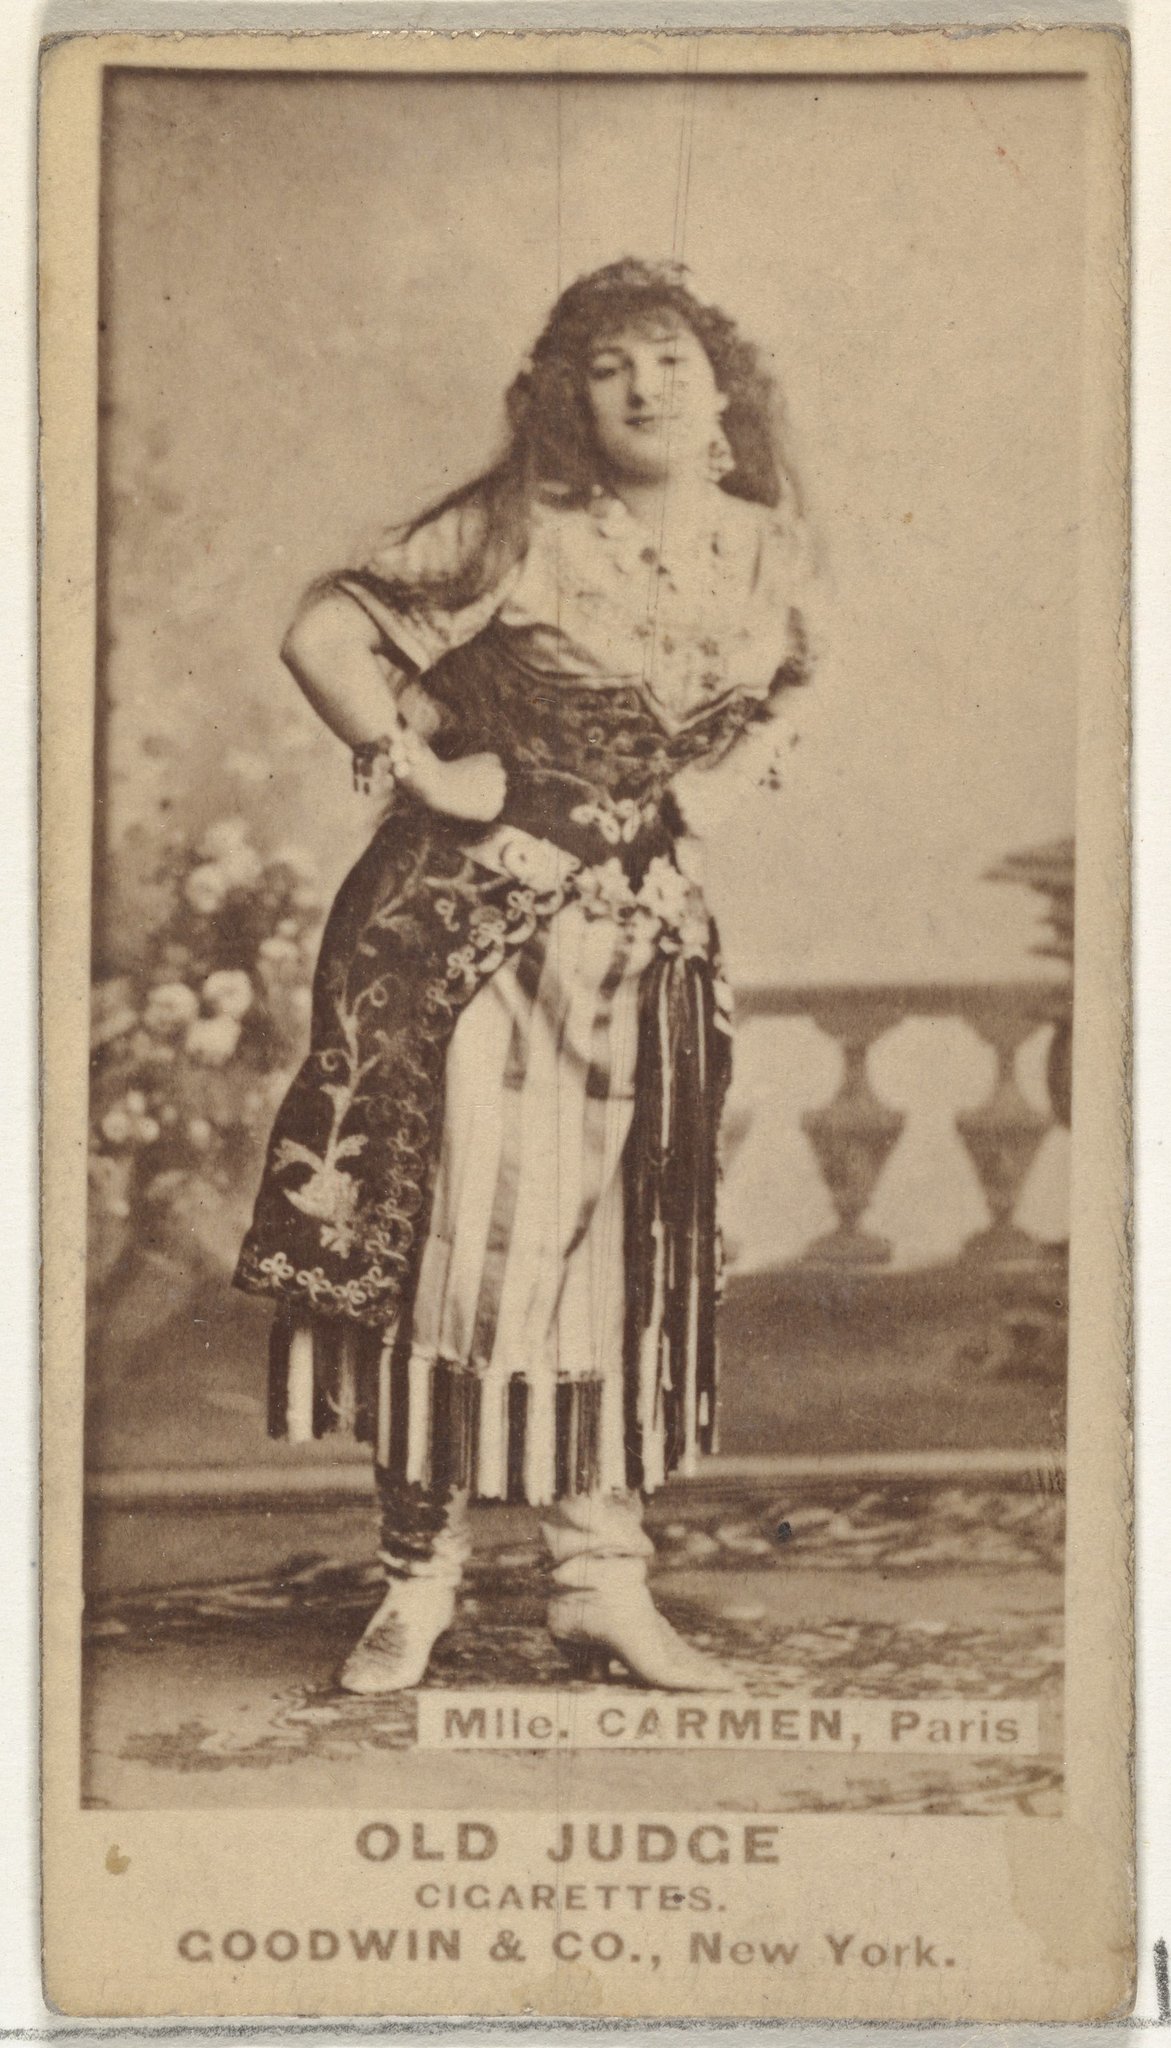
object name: photograph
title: Mlle. Carmen, Paris, from the Actors and Actresses series (N171) for Old Judge Cigarettes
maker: goodwin & company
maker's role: publisher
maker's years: 1850-1950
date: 1886-1890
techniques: albumen silver print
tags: portraits,women,actresses